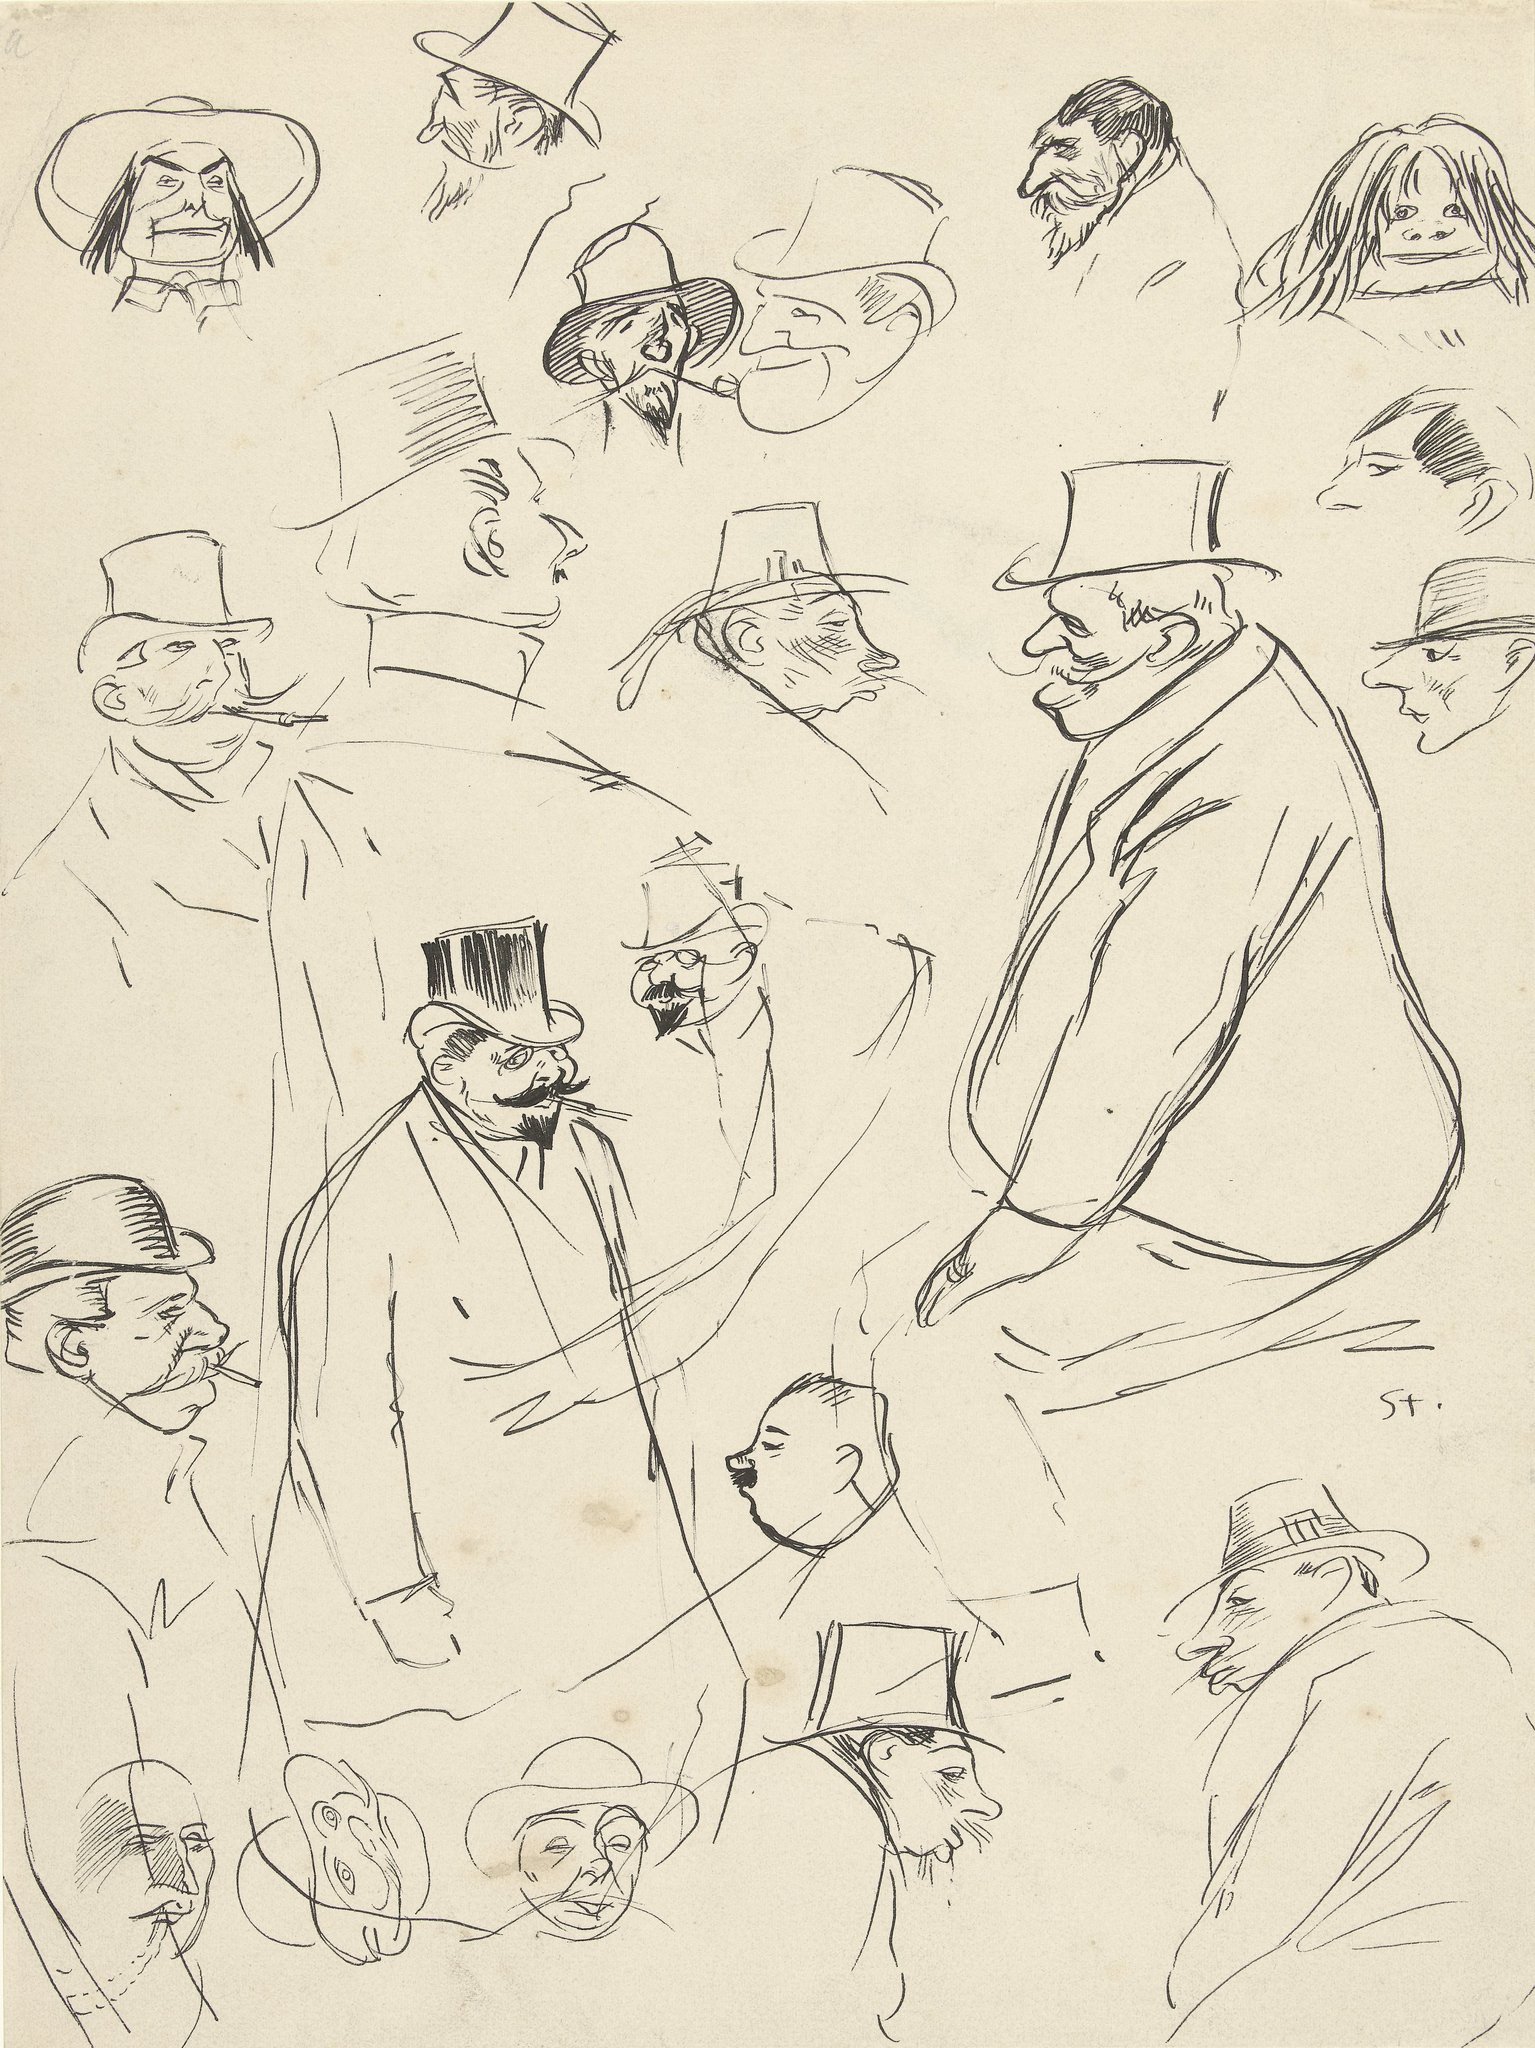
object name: drawing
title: Karikaturale portret- en figuurstudies van mannen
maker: théophile alexandre steinlen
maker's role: draughtsman, painter, print maker, sculptor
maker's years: 1859-1923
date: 1869-1923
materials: ink, paper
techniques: pen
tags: head (human), caricatures (human types)